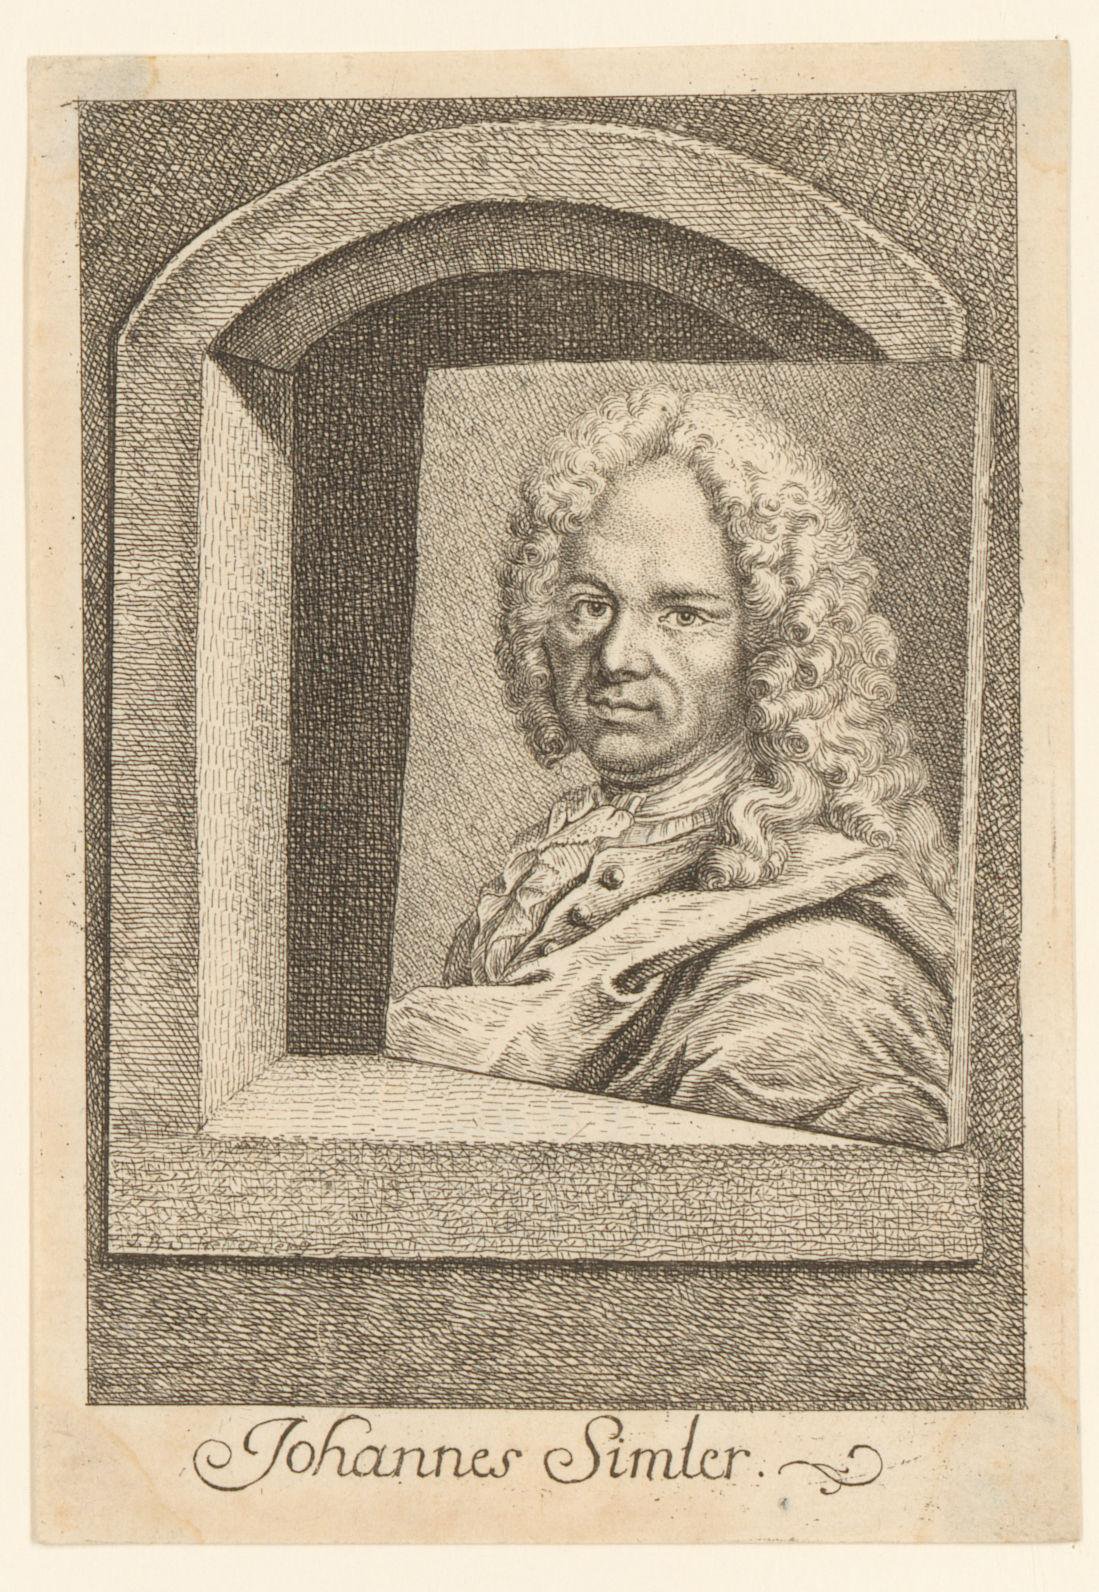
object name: print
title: Portret van Johann Simmler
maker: johann rudolph schellenberg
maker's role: print maker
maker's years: 1740-1806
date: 1750-1806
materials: paper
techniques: etching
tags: painter, johann simmler, portrait, self-portrait of artist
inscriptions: collector's mark: Lugt 2228